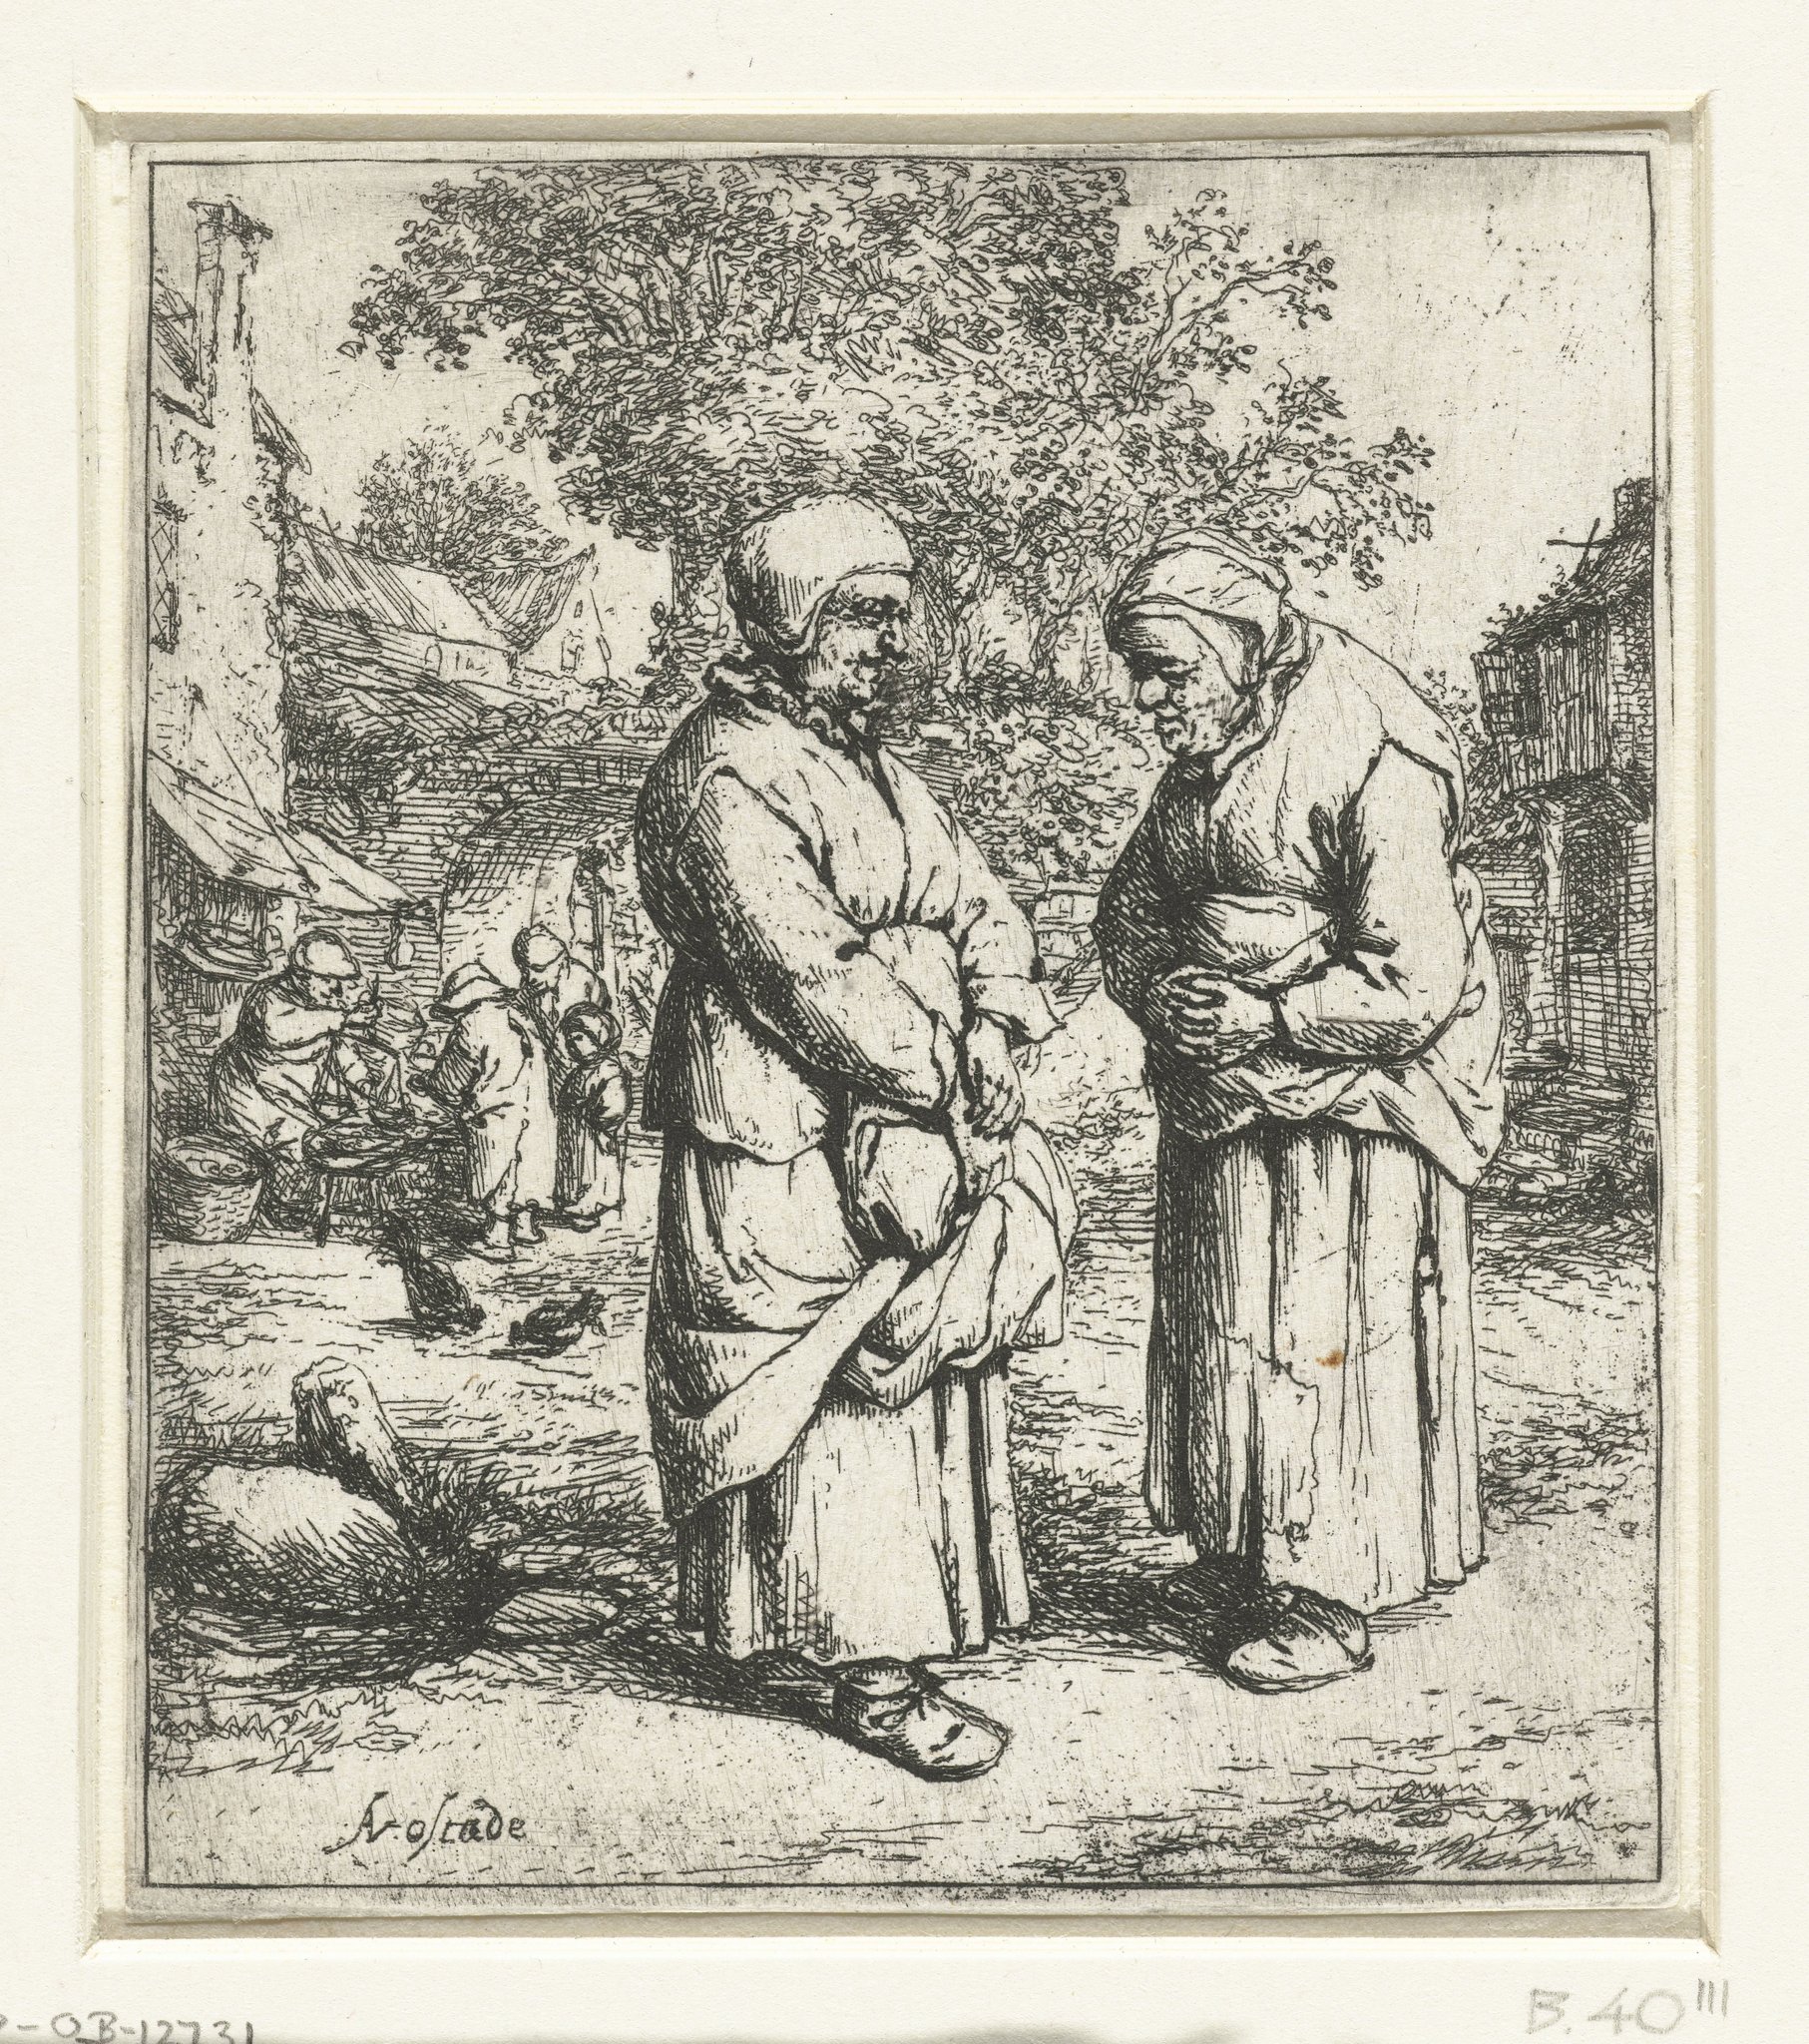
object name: print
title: Twee oude vrouwen in gesprek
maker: adriaen van ostade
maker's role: draughtsman, painter, print maker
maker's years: 1610-1685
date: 1648-1654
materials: paper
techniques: etching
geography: haarlem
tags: old woman, conversation, dialogue; conversation piece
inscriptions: collector's mark: Lugt 240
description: In een dorpsstraat zijn twee oude vrouwen met elkaar in gesprek, enkele figuren staan bij een winkeltje op de achtergrond